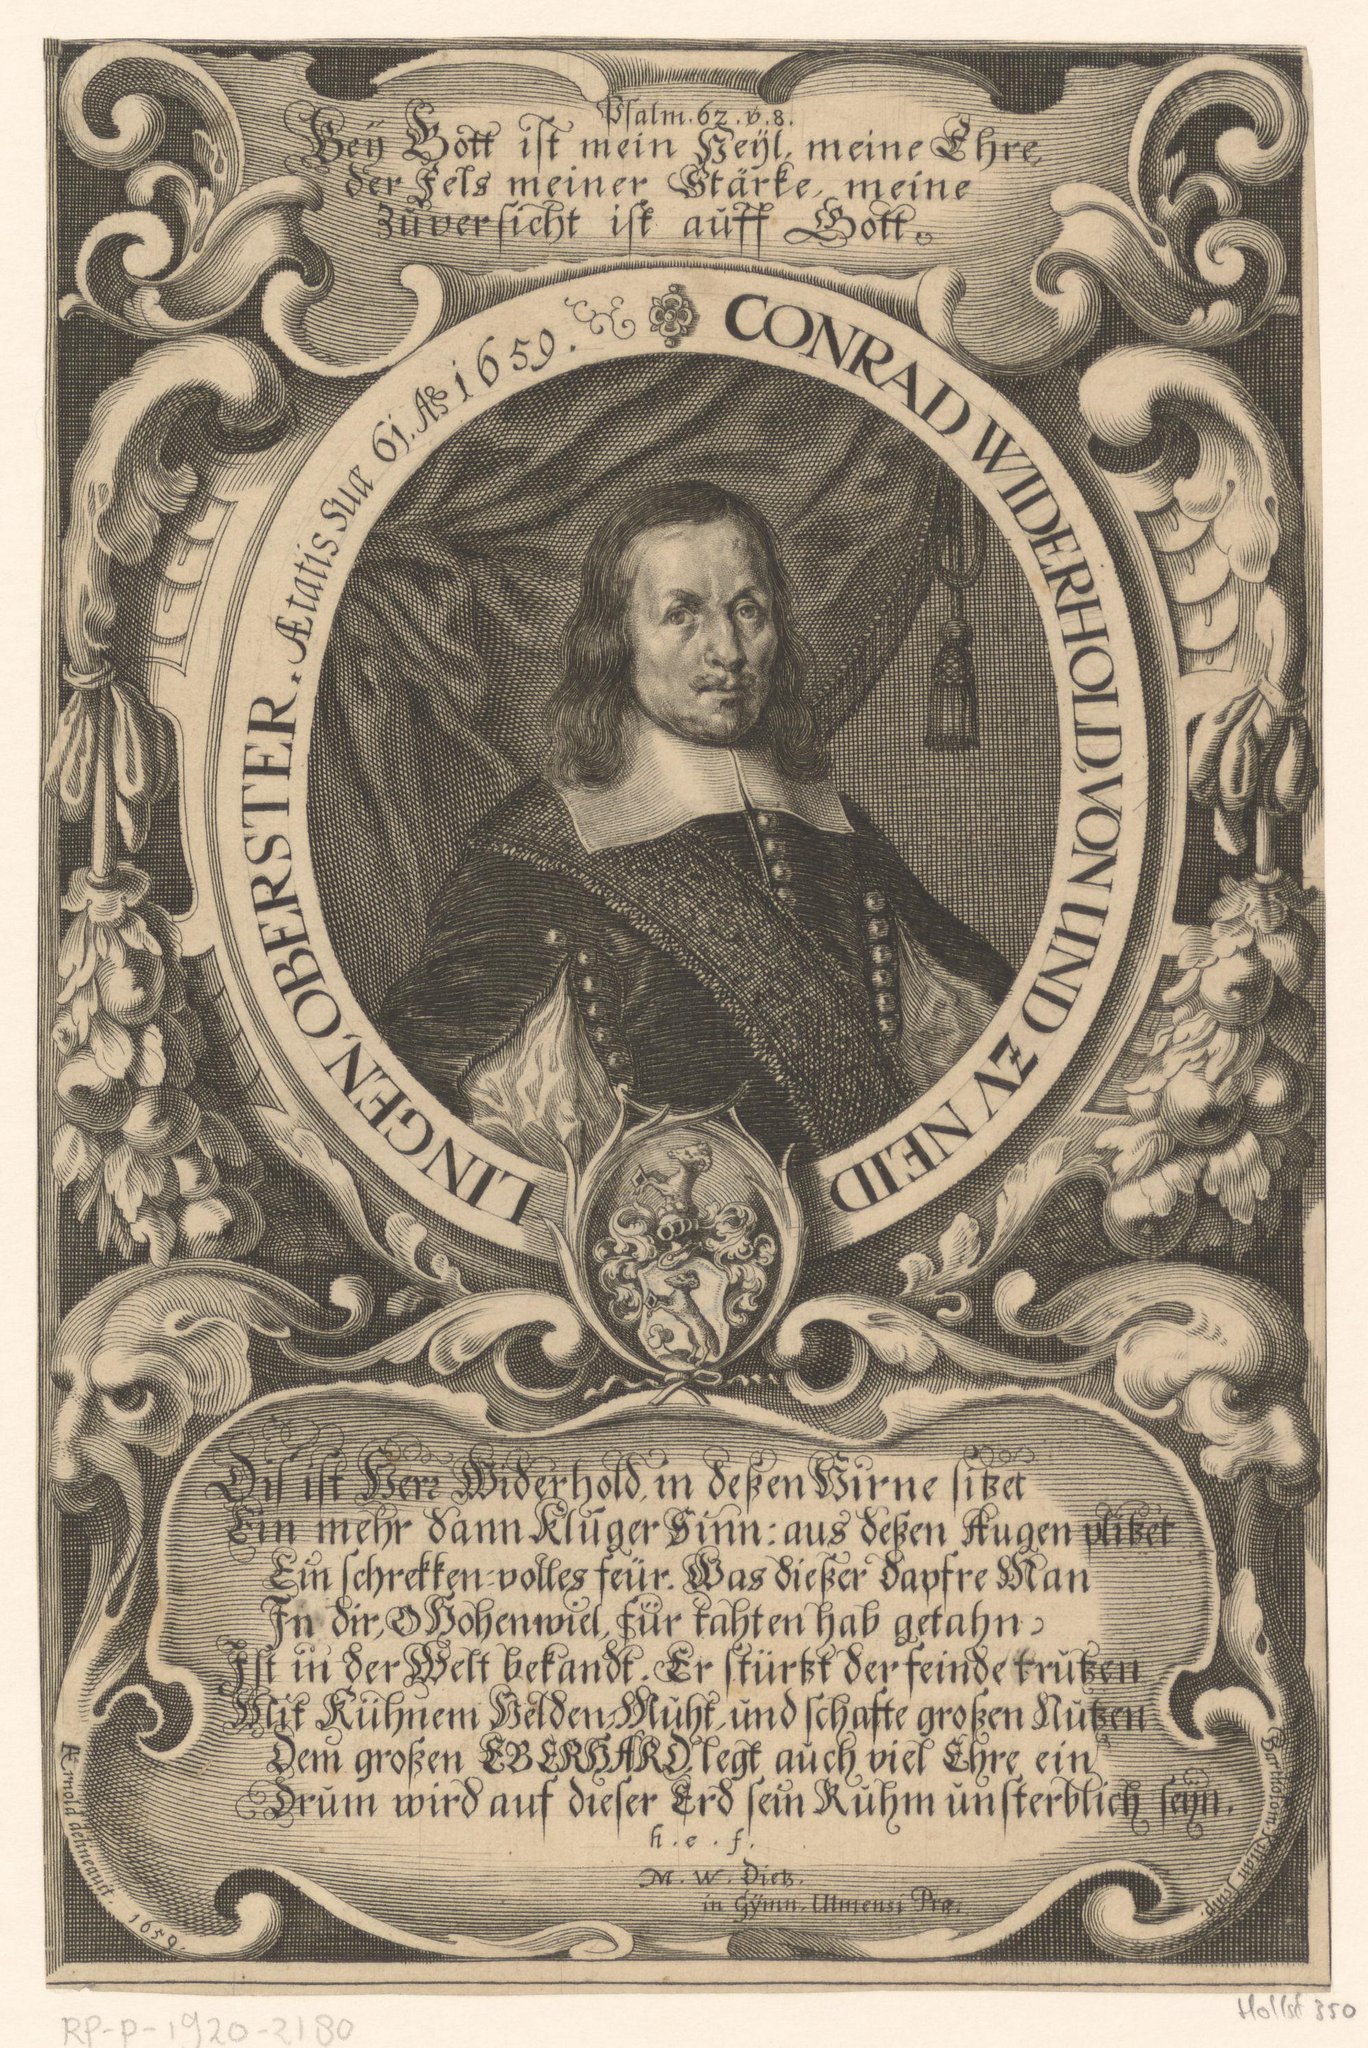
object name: print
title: Portret van Konrad Wiederhold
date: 1659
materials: paper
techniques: engraving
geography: ulm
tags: historical persons, officer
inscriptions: collector's mark: Lugt 2228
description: Tekst in het Latijn in de omlijsting en in de cartouche onder- en bovenaan.